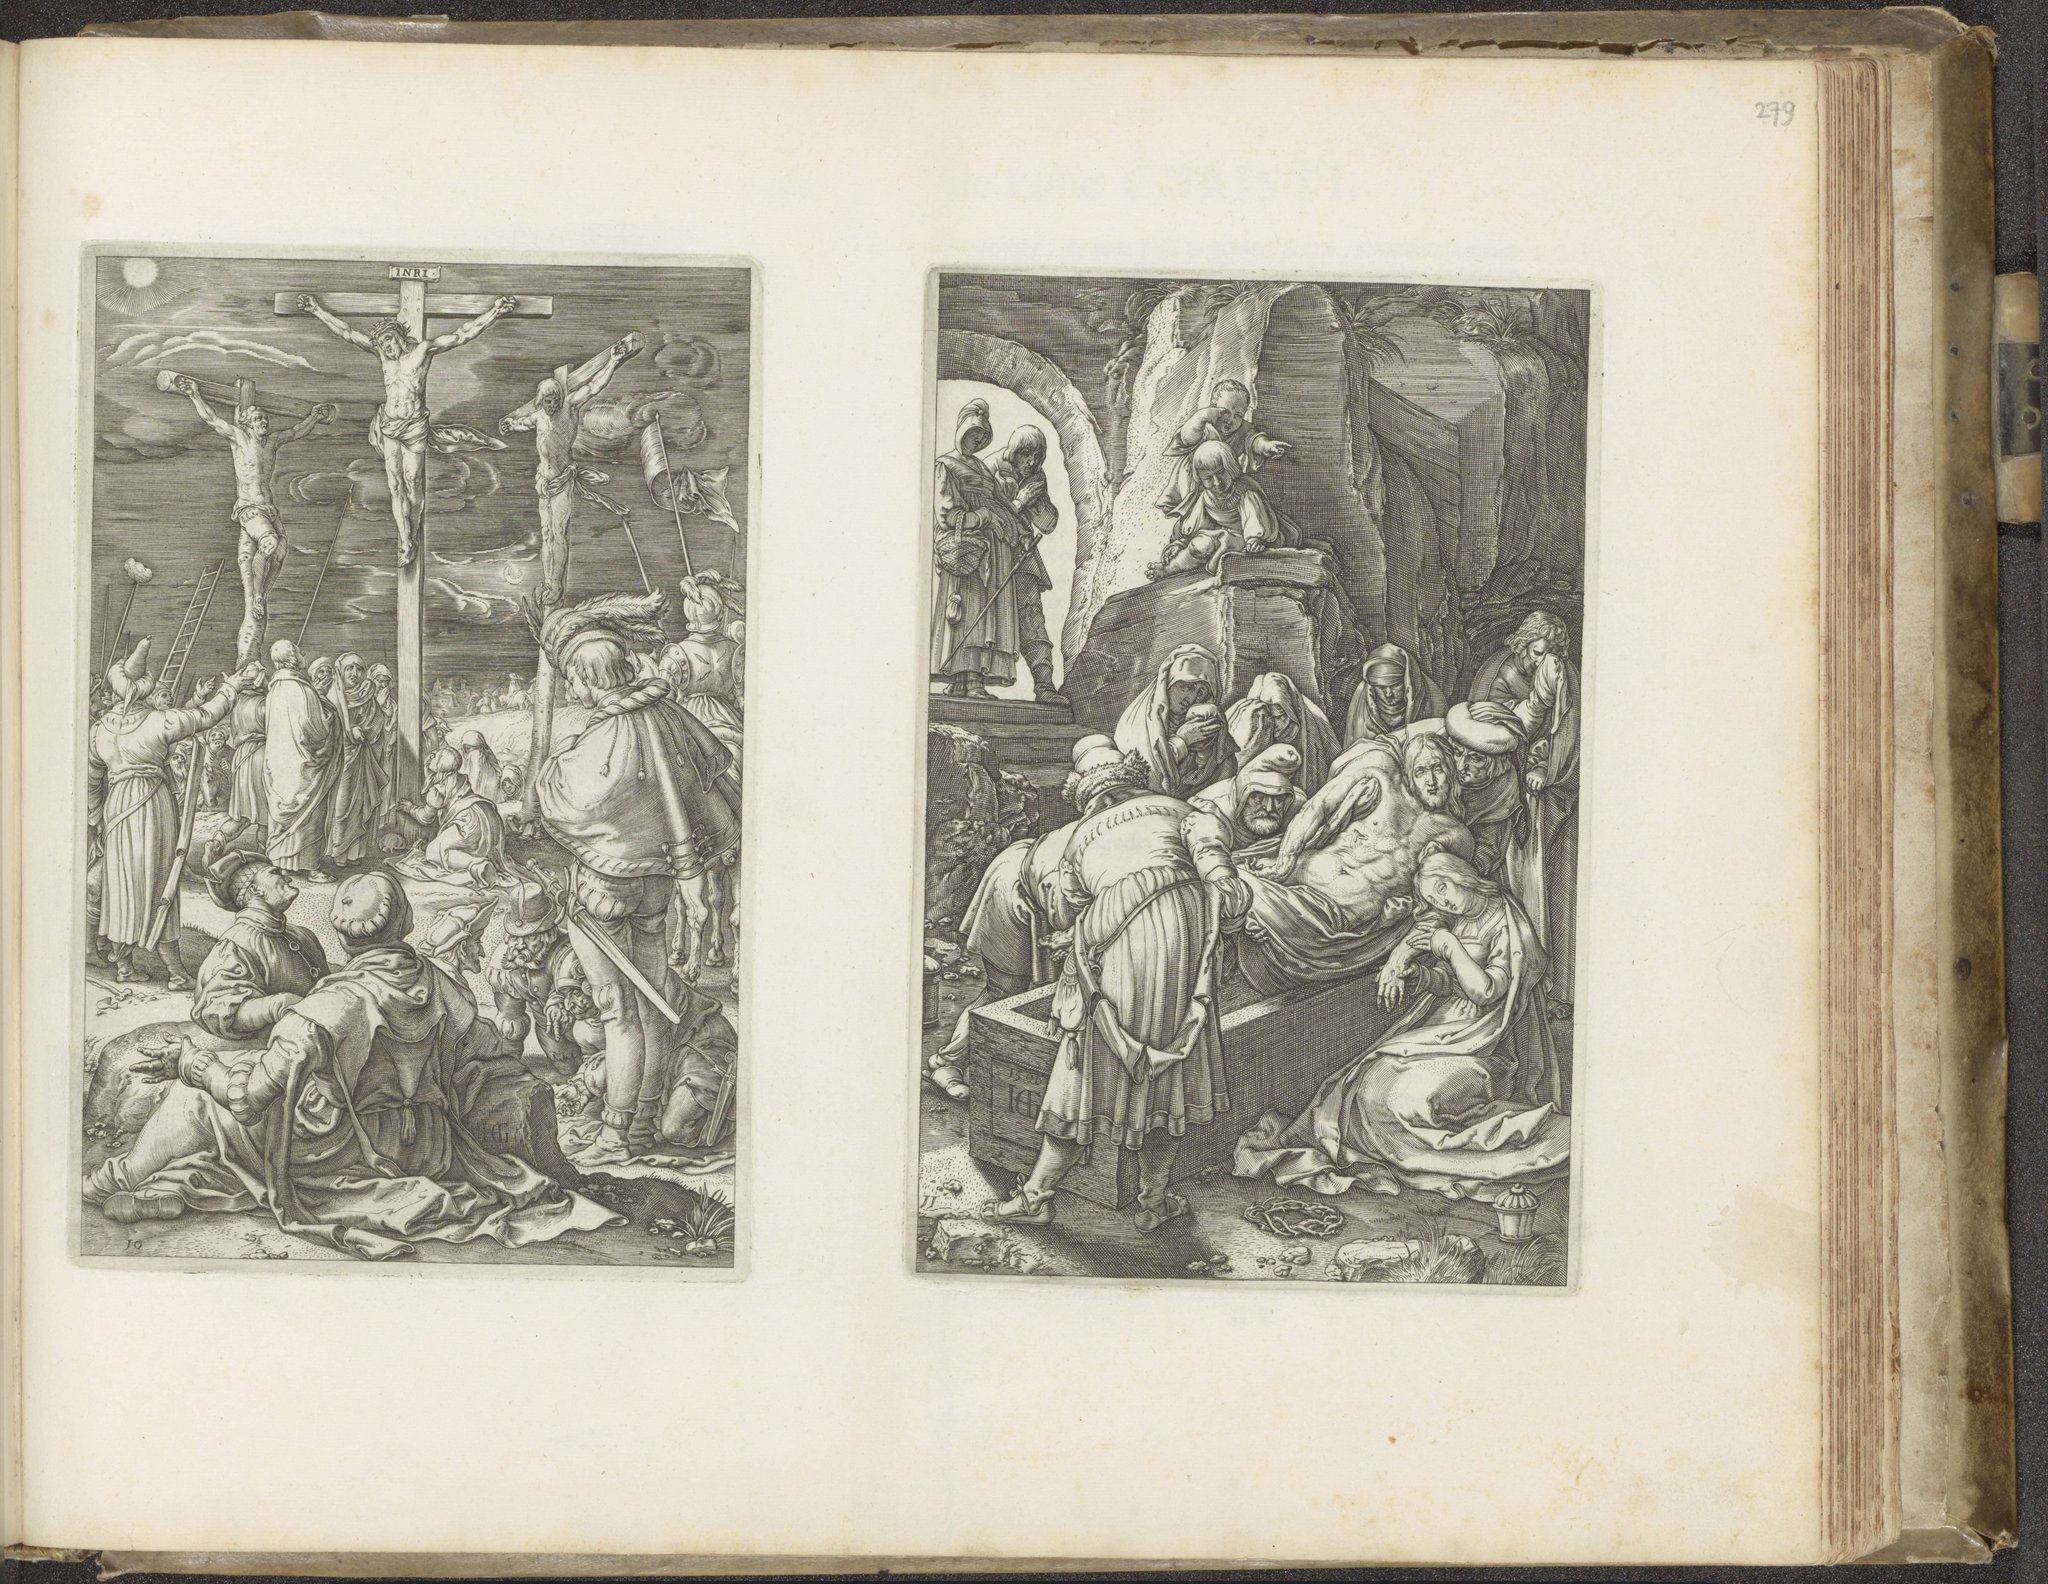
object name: print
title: Passie van Christus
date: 1596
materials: paper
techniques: engraving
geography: amsterdam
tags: christ's entombment (possibly by angels), christ's body on or in the grave, the crucifixion of christ: christ's death on the cross; golgotha (matthew 27:45-58; mark 15:33-45; luke 23:44-52; john 19:25-38)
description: Twee voorstellingen op een albumblad. Links Christus aan het kruis tussen de twee andere gekruisigden. Aan de voet van het kruis onder anderen de drie Maria's en Longinus met zijn lans. Op de voorgrond de soldaten die dobbelen om zijn kleding. Op de rechter voorstelling wordt Christus in een grot door een aantal mannen in een graf gelegd. De Maria's en de apostel Johannes staan er huilend bij. Op de voorgrond de doornenkroon en de zalfpot van Maria Magdalena. Het blad maakt deel uit van een album.